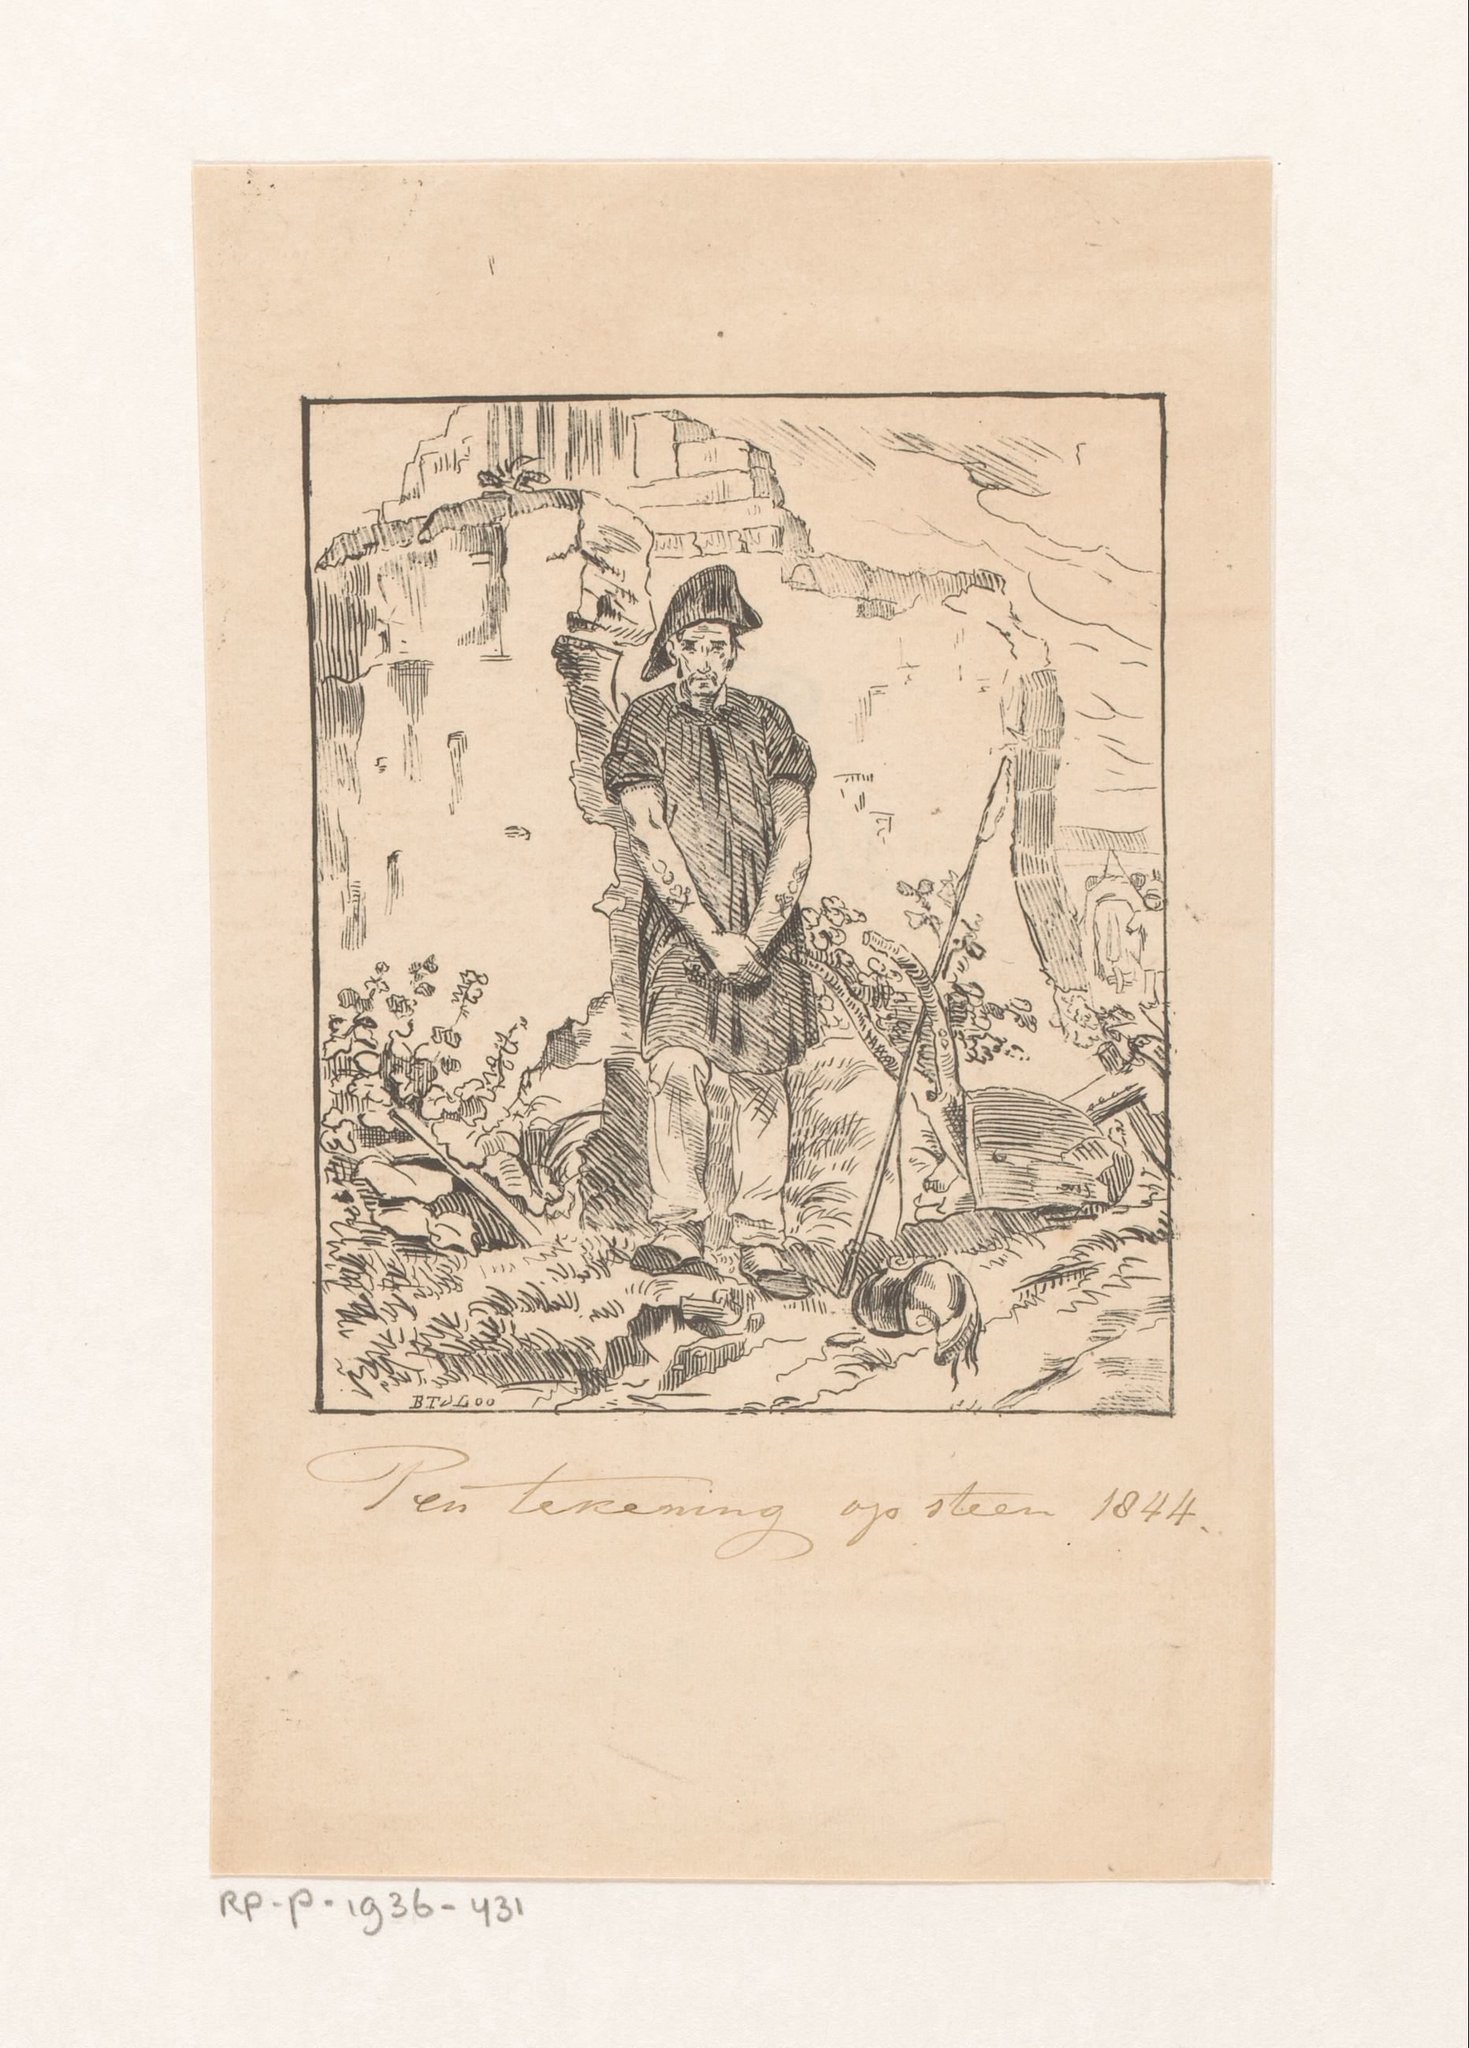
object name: print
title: Soldaat of piraat bij ruïne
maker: bernardus theodorus van loo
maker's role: print maker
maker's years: 1816-1892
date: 1844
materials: paper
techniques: lithograph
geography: nieuwer-amstel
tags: pirate, corsair, buccaneer, ruin of a building ~ architecture, tattoo, whip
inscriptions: inscription: ‘Pen tekening op steen 1844’, collector's mark: Lugt 2228, collector's mark: Lugt 2760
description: De man staat voor een muur met zijn armen gekruist voor zich. Op zijn armen tatoeages met harten en sabels. Naast hem een zweep. Achter de ruïne een figuur.